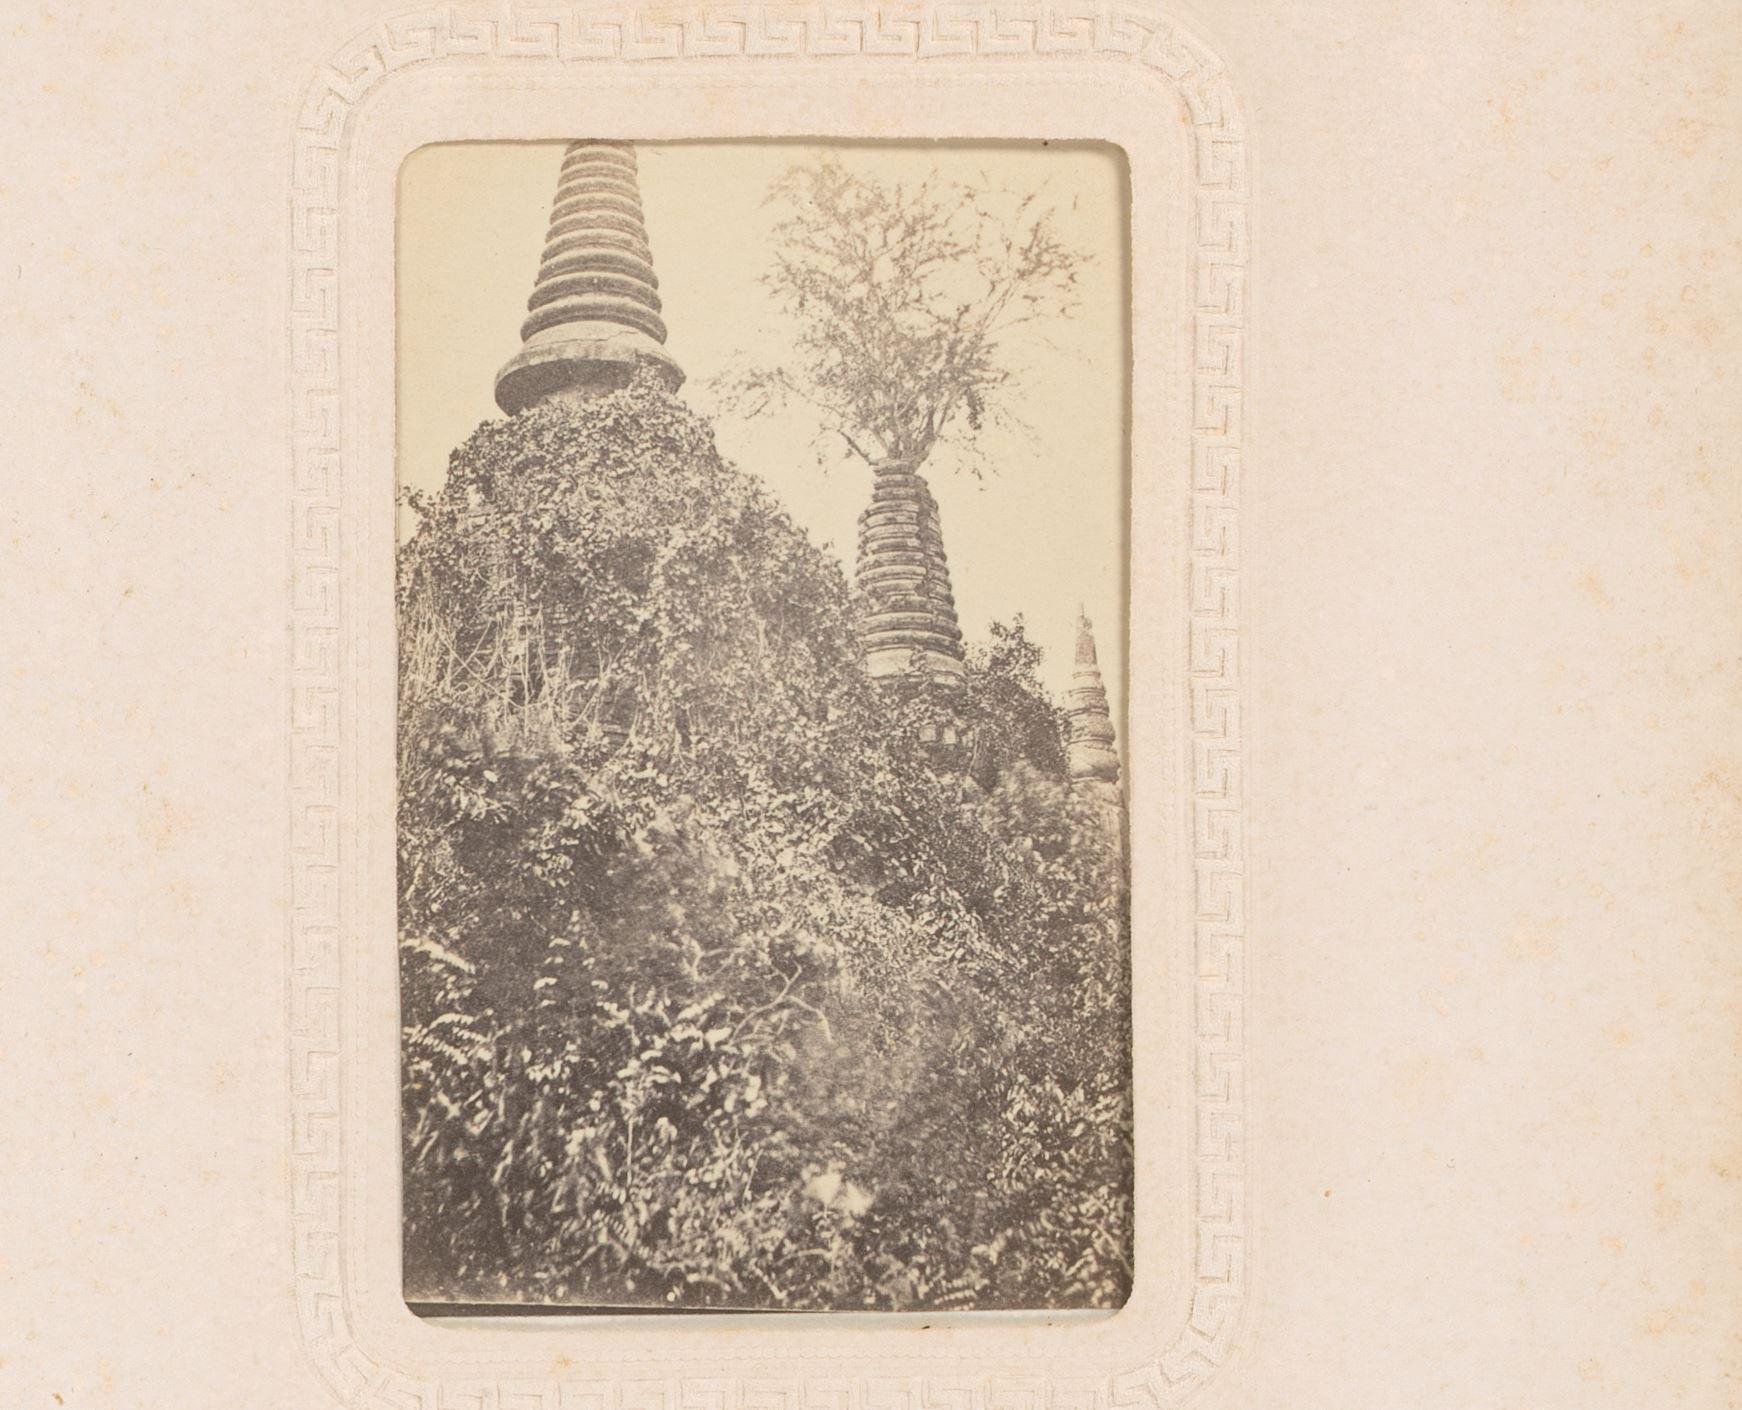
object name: album leaf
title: Koninklijke graven te Thailand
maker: Anonymous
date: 1850-1880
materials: cardboard, photographic support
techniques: albumen print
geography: thailand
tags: grave-building, monumental tomb, thailand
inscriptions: number: ‘66’, annotation: ‘Graven van koningen in Siam’